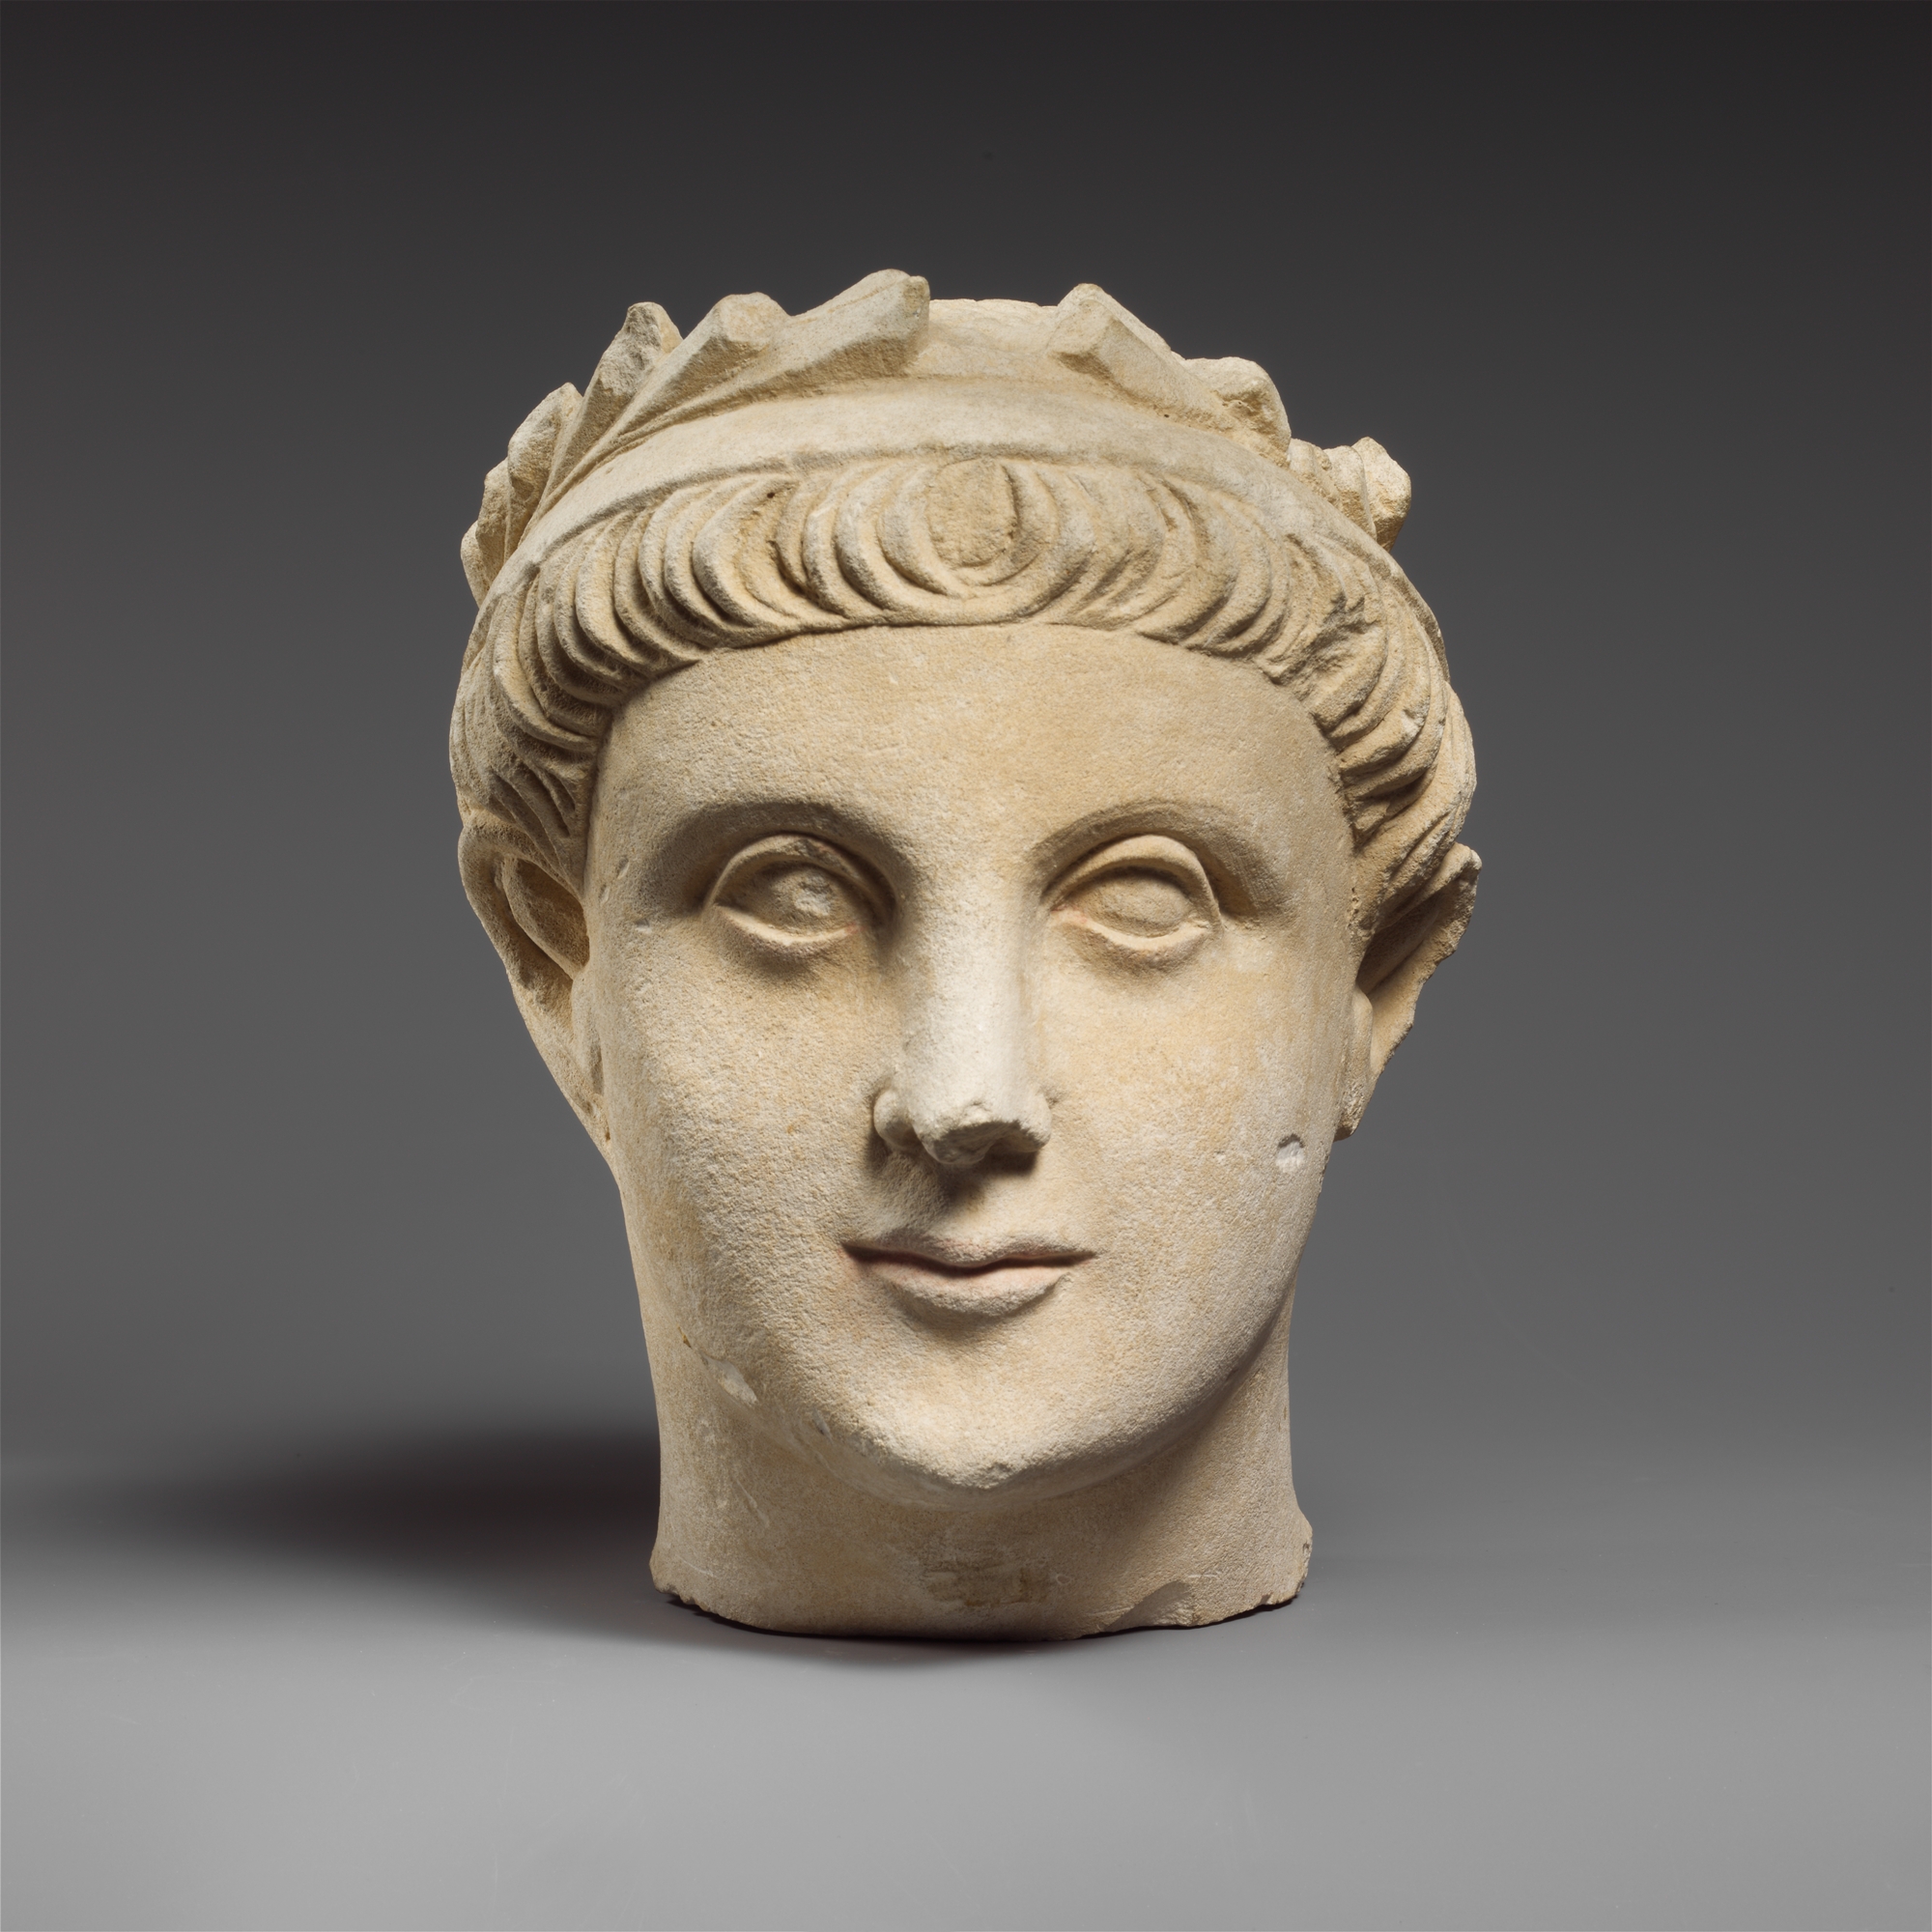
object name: head of a votary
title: Limestone head of a wreathed youth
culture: cypriot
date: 434-301 BCE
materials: limestone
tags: heads,men,wreaths